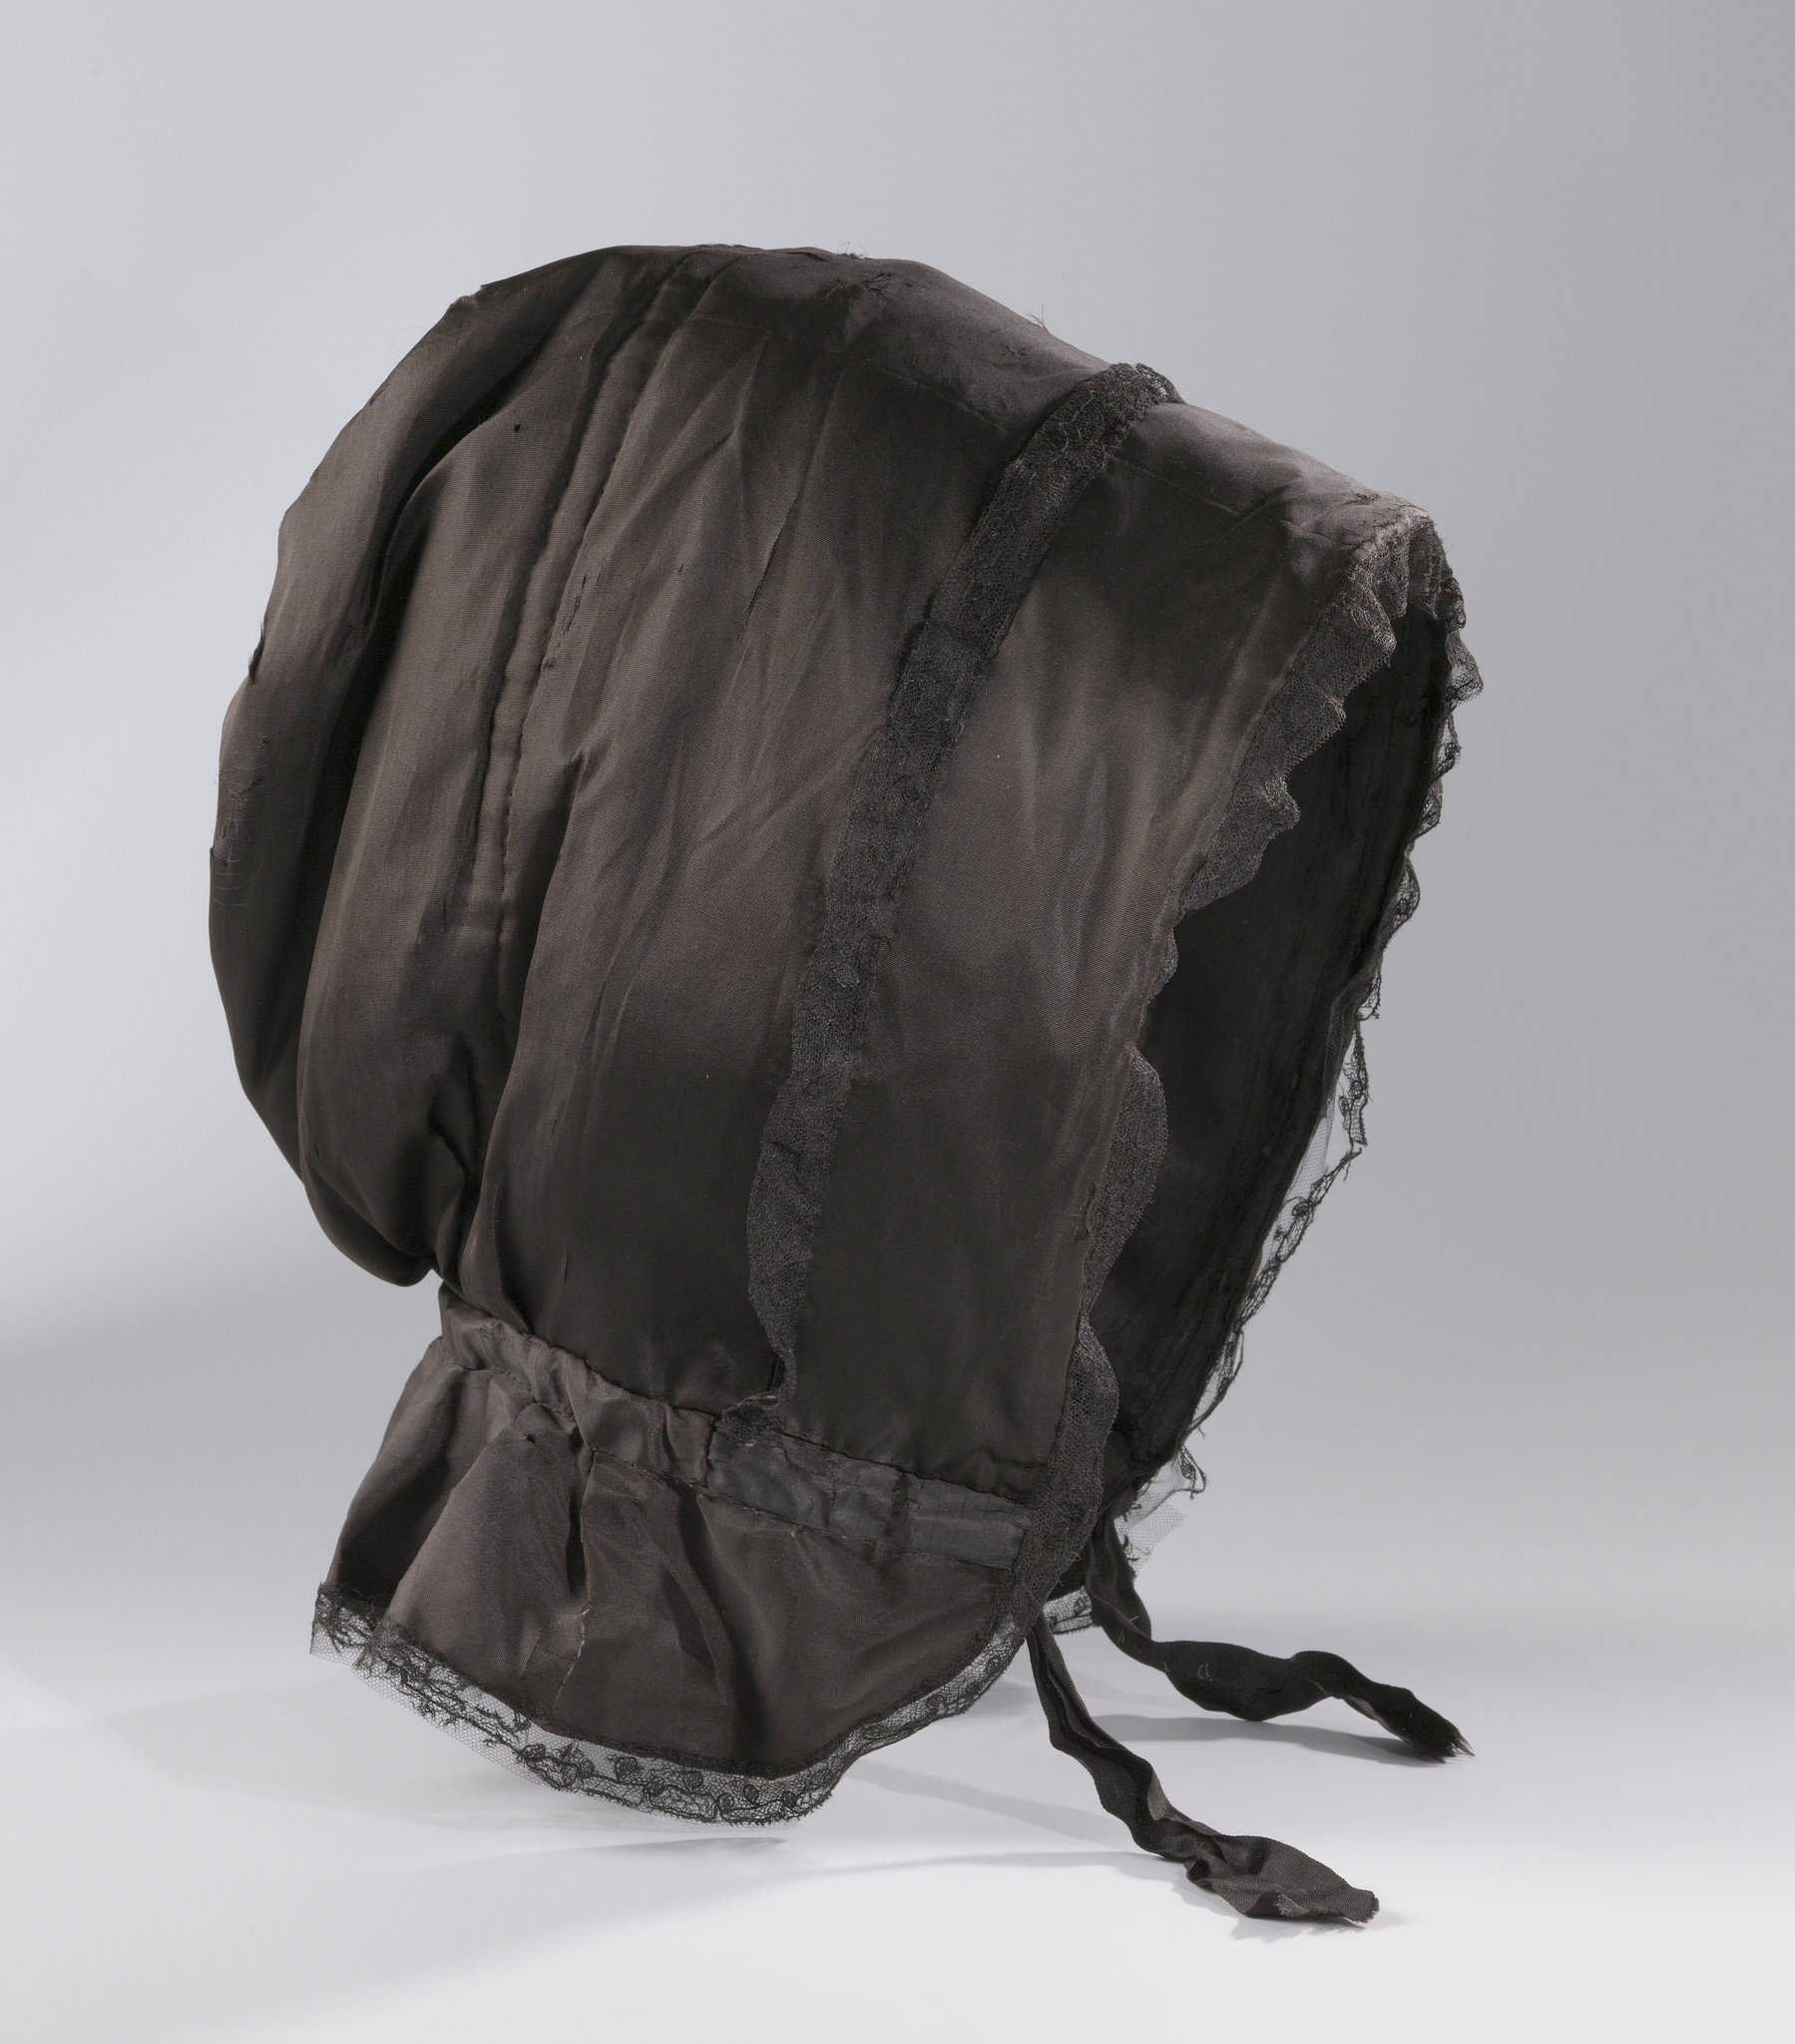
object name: calash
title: Kap of calèche (Thérèse) van gewatteerde zwarte ripszijde, oorspronkelijk gesteund door drie (één ontbreekt) baleinen, gevoerd met zwarte zijde en afgezet met zwarte kant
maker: Anonymous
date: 1775-1783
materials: textile, silk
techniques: padding, weave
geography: netherlands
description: Kap of calèche van gewatteerde zwarte ripszijde. Rond het gezicht is een 1 cm breed lint anagebracht als tunnel voor een dunne, metalen (?) balein. Onder aan de kap een tunnel waardoor een zwart satijnen lint kan worden aangetrokken ter sluiting onder de kin. Hieraan is een loss strook gerimpeld, die tot op de schouders valt. Aan de voorkant van de kap een brede teruggeslagen rand zijde. Halverwege de kap een tunnel waaruit de balein ontbreekt. De kap wordt aan de achterkant gesloten door midddel van aanrimpelen vanuit één centraal punt in het midden. Het materiaal van de vulling is vooralsnog onbekend.